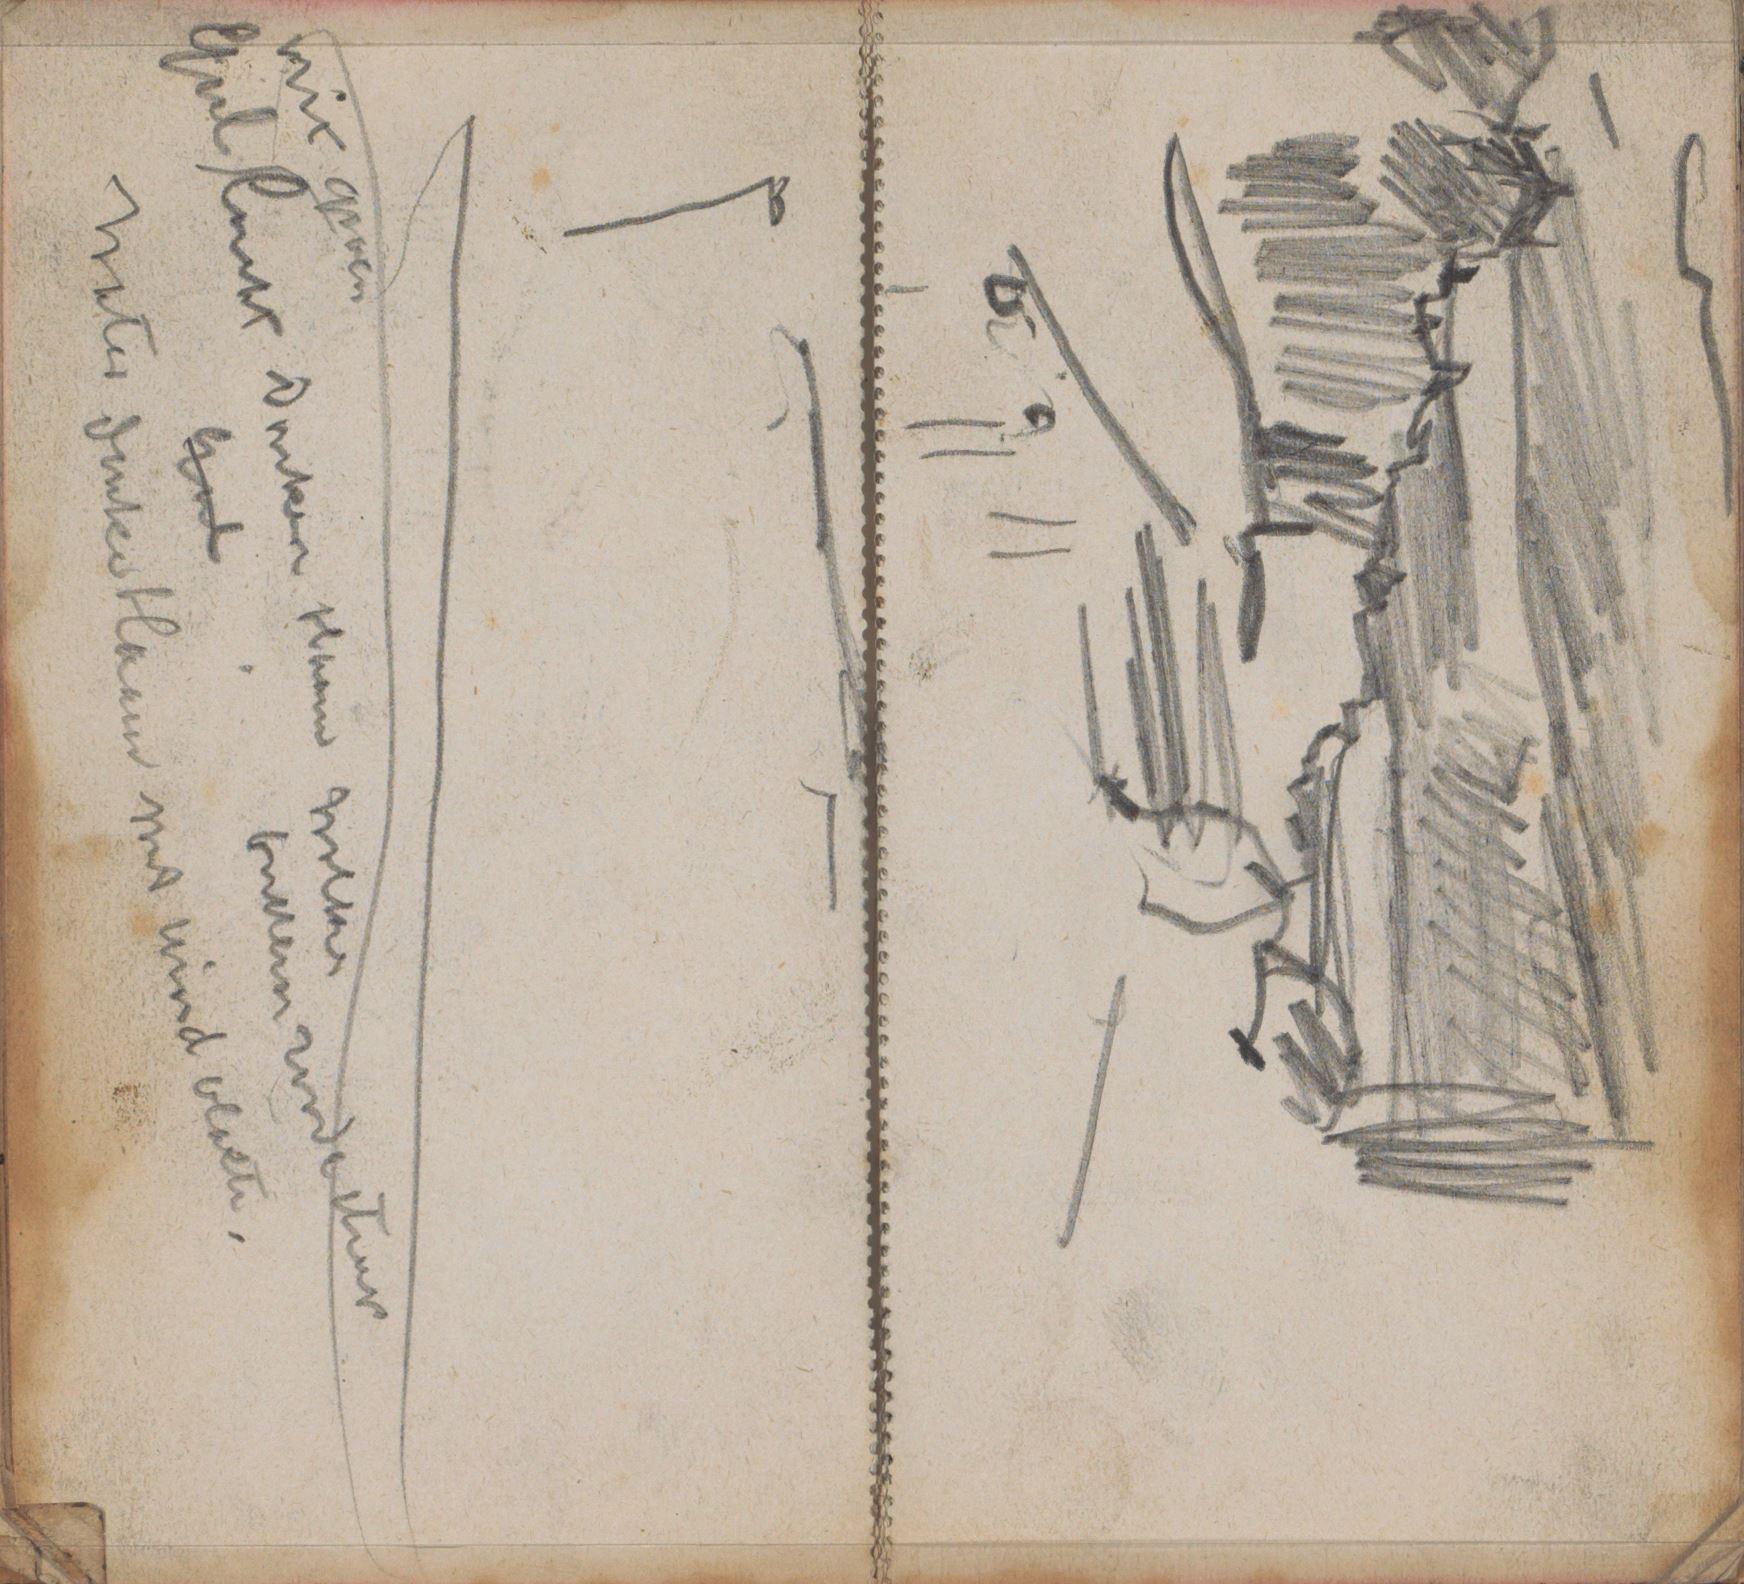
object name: sketchbook leaf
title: Gezicht op gebouwen aan het water te Amsterdam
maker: george hendrik breitner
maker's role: draughtsman, painter, print maker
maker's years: 1857-1923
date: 1893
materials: paper, pencil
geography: amsterdam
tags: urban housing, canals, waters (in city)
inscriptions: : ‘wit groen/ geel lucht donker blauw wolken/ onderen roode streep/ water donkerblauw met wind [...]’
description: Gezicht op gebouwen aan het water te Amsterdam, mogelijk het Rokin of het Damrak. Pagina 19 en pagina 20 uit een schetsboek met 22 bladen vervaardigd te Amsterdam.